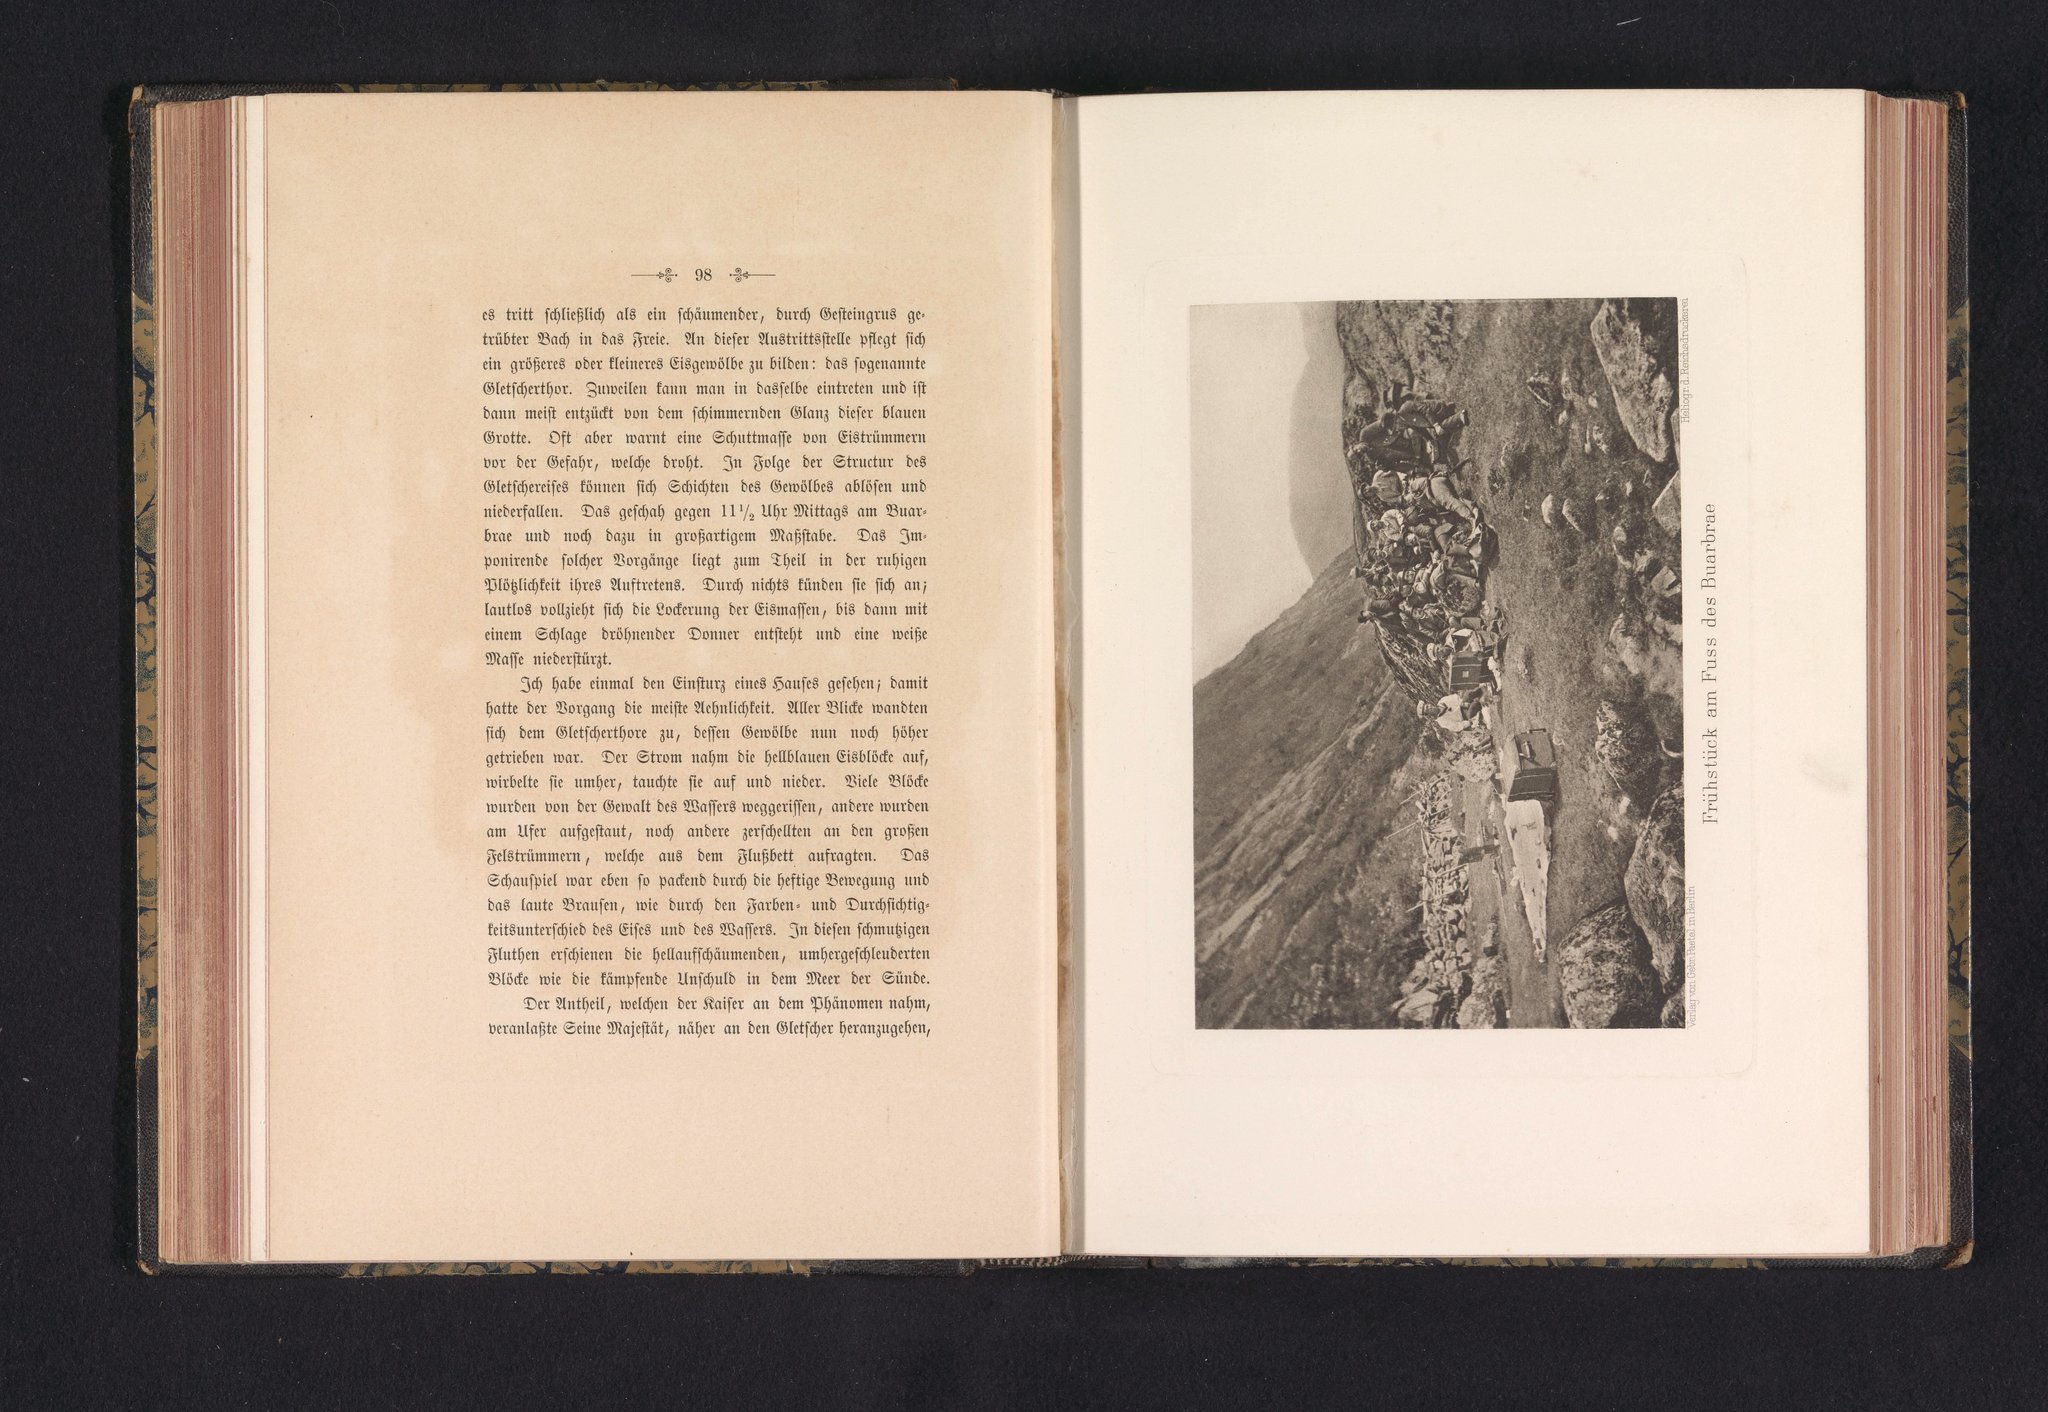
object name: page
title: Frühstück am Fuss des Buarbrae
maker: Anonymous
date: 1889-1892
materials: paper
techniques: photoaquatint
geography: berlin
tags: anonymous historical persons portrayed in a group, in a group-portrait